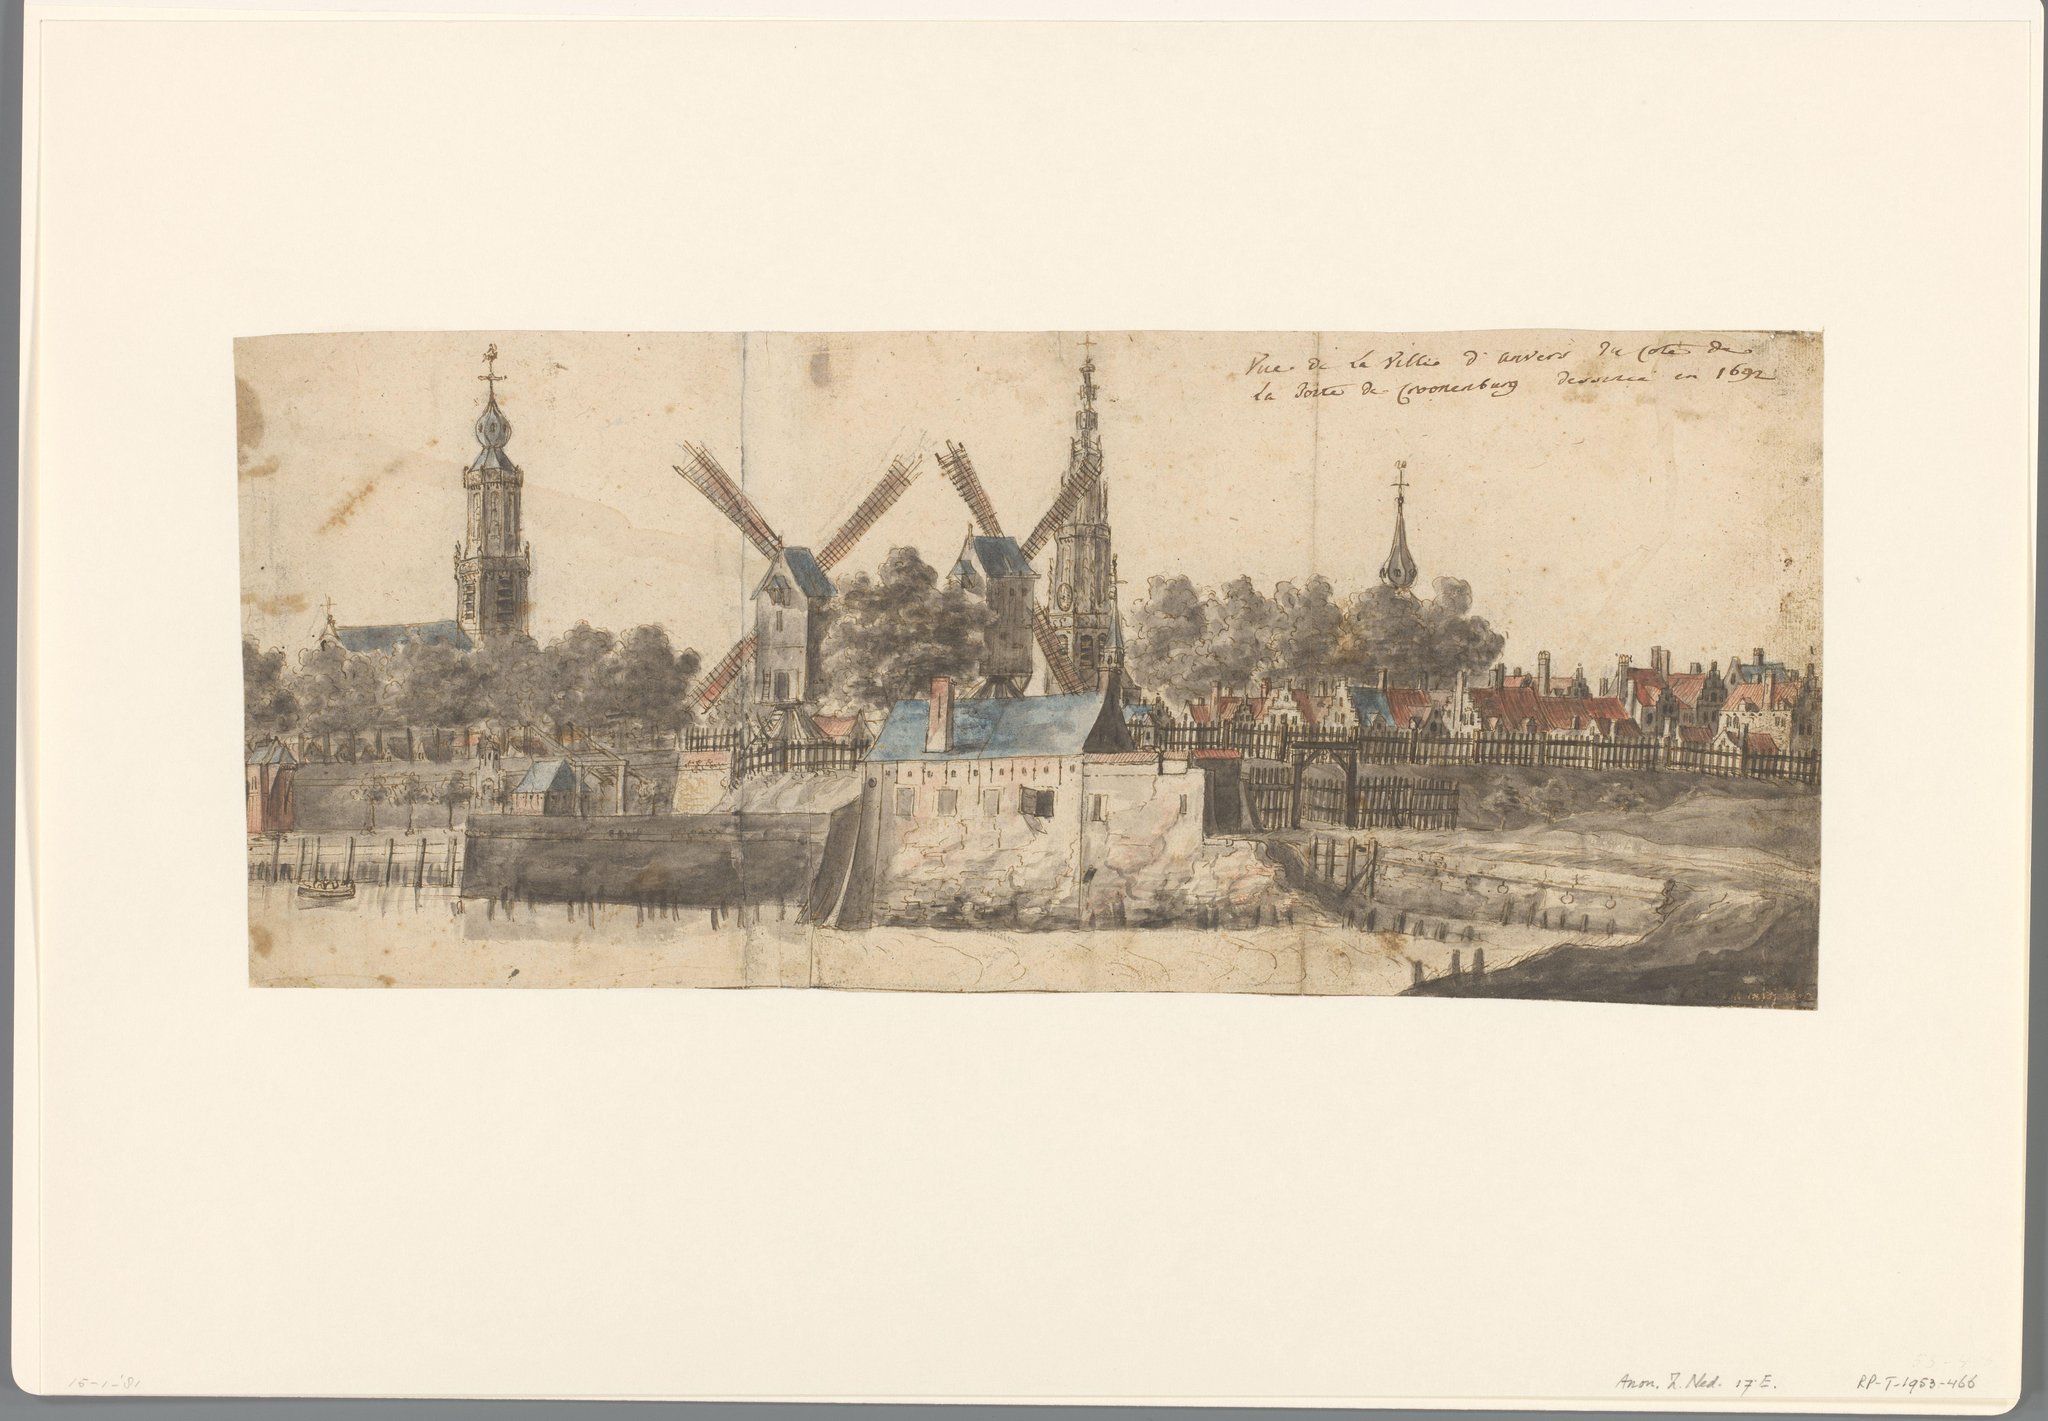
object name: watercolor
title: Gezicht op Antwerpen, uit het zuiden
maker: Anonymous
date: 1692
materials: paper, watercolor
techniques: brush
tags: prospect of city, town panorama, silhouette of city, antwerp